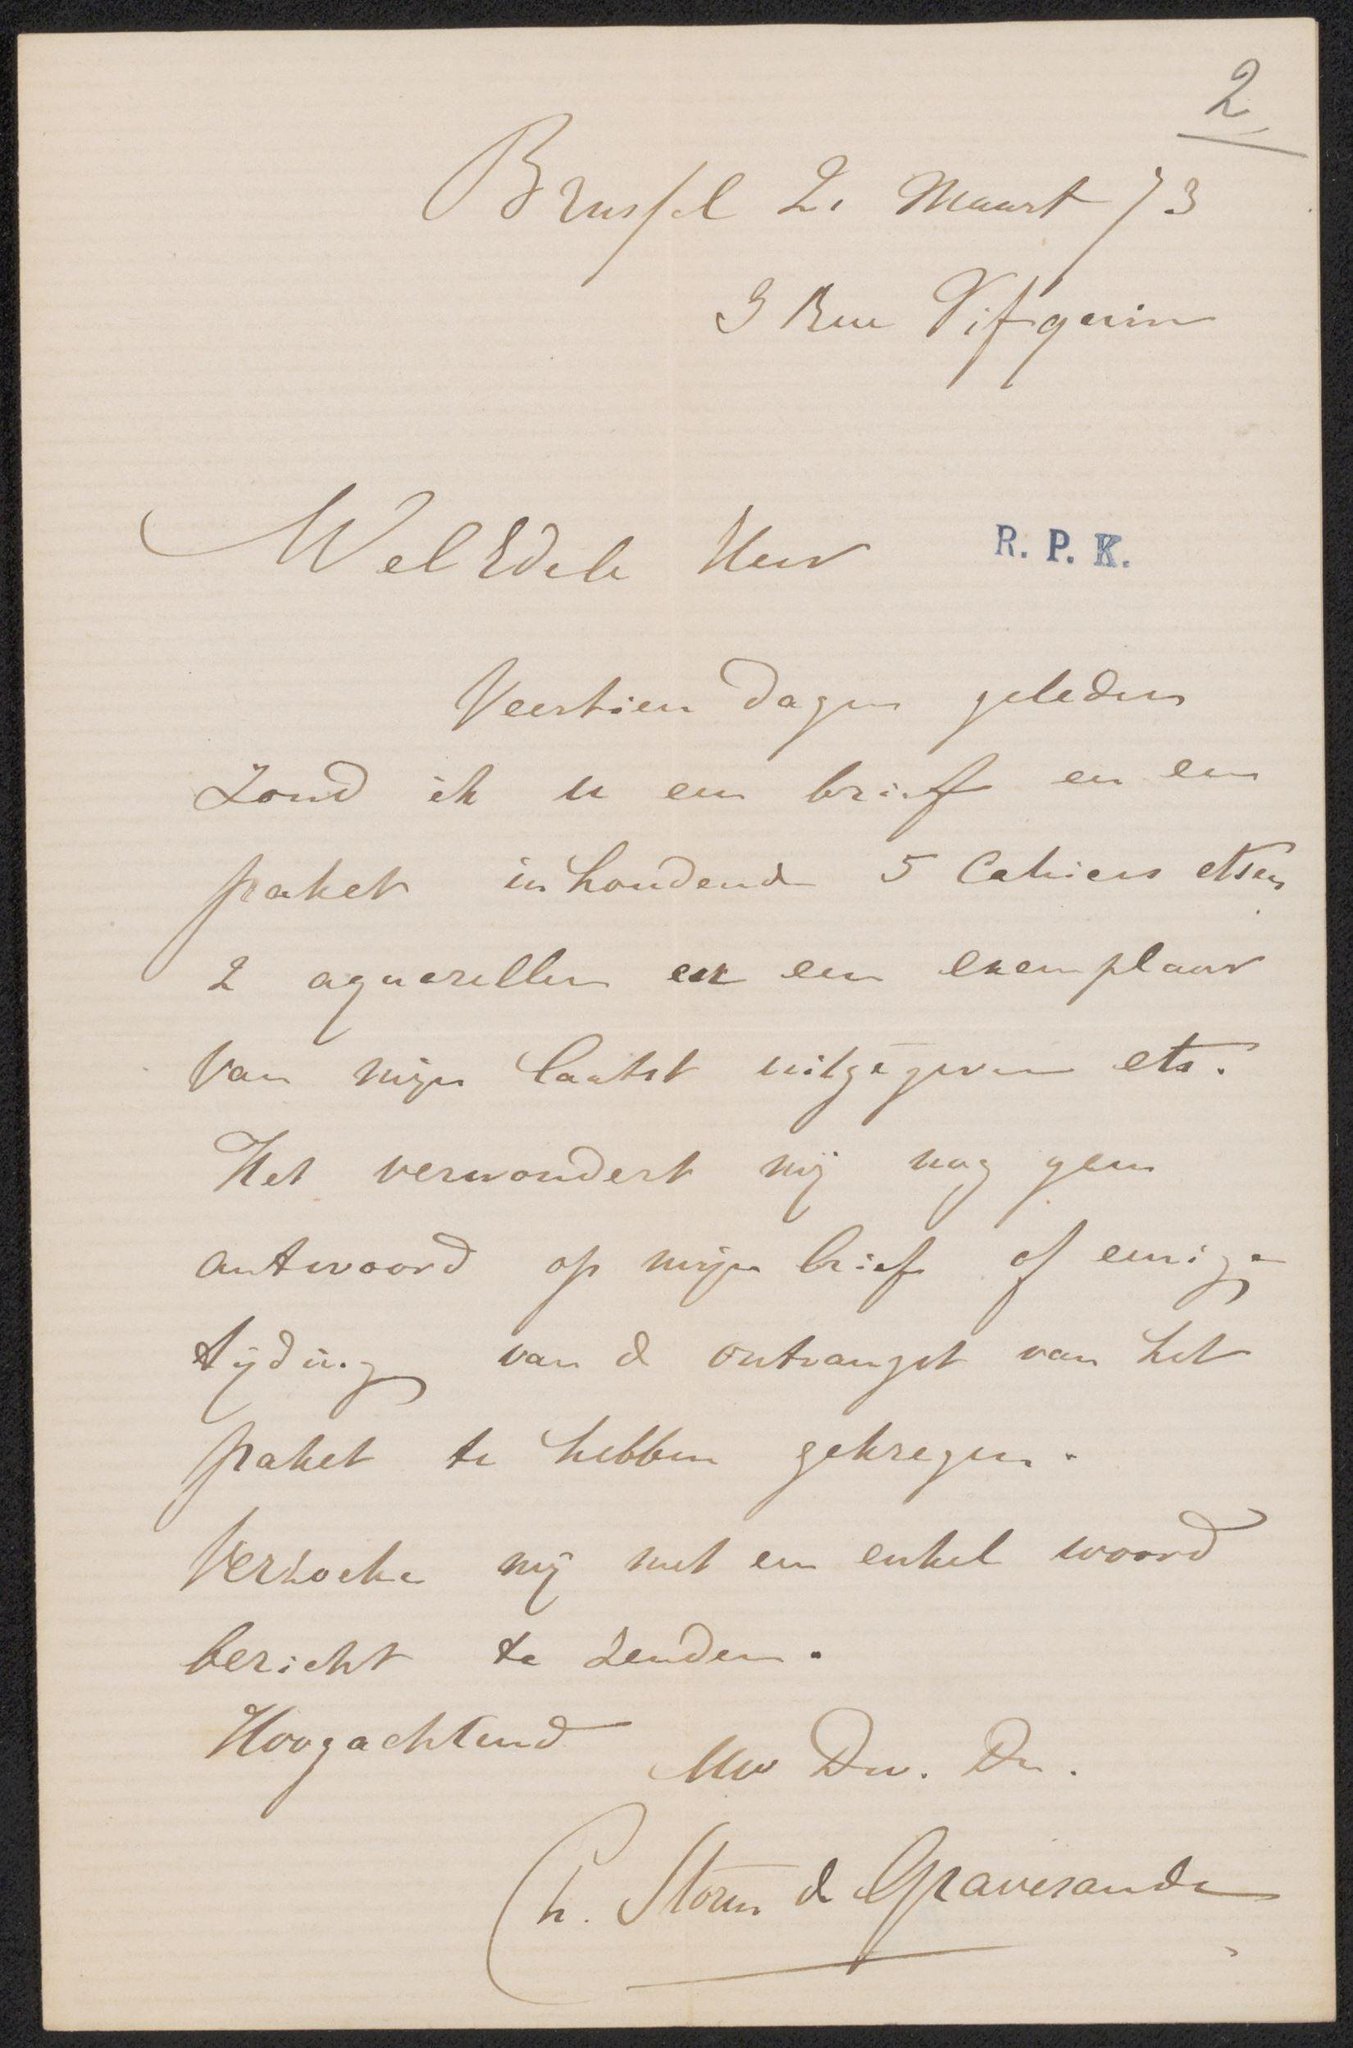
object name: letter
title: Brief aan Frans Buffa en Zonen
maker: carel nicolaas storm van s-gravesande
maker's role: draughtsman, print maker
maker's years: 1841-1924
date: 1873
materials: ink, paper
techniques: pen, writing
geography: brussels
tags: publisher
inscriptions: collector's mark: ‘RPK’, collector's mark: Lugt 2233